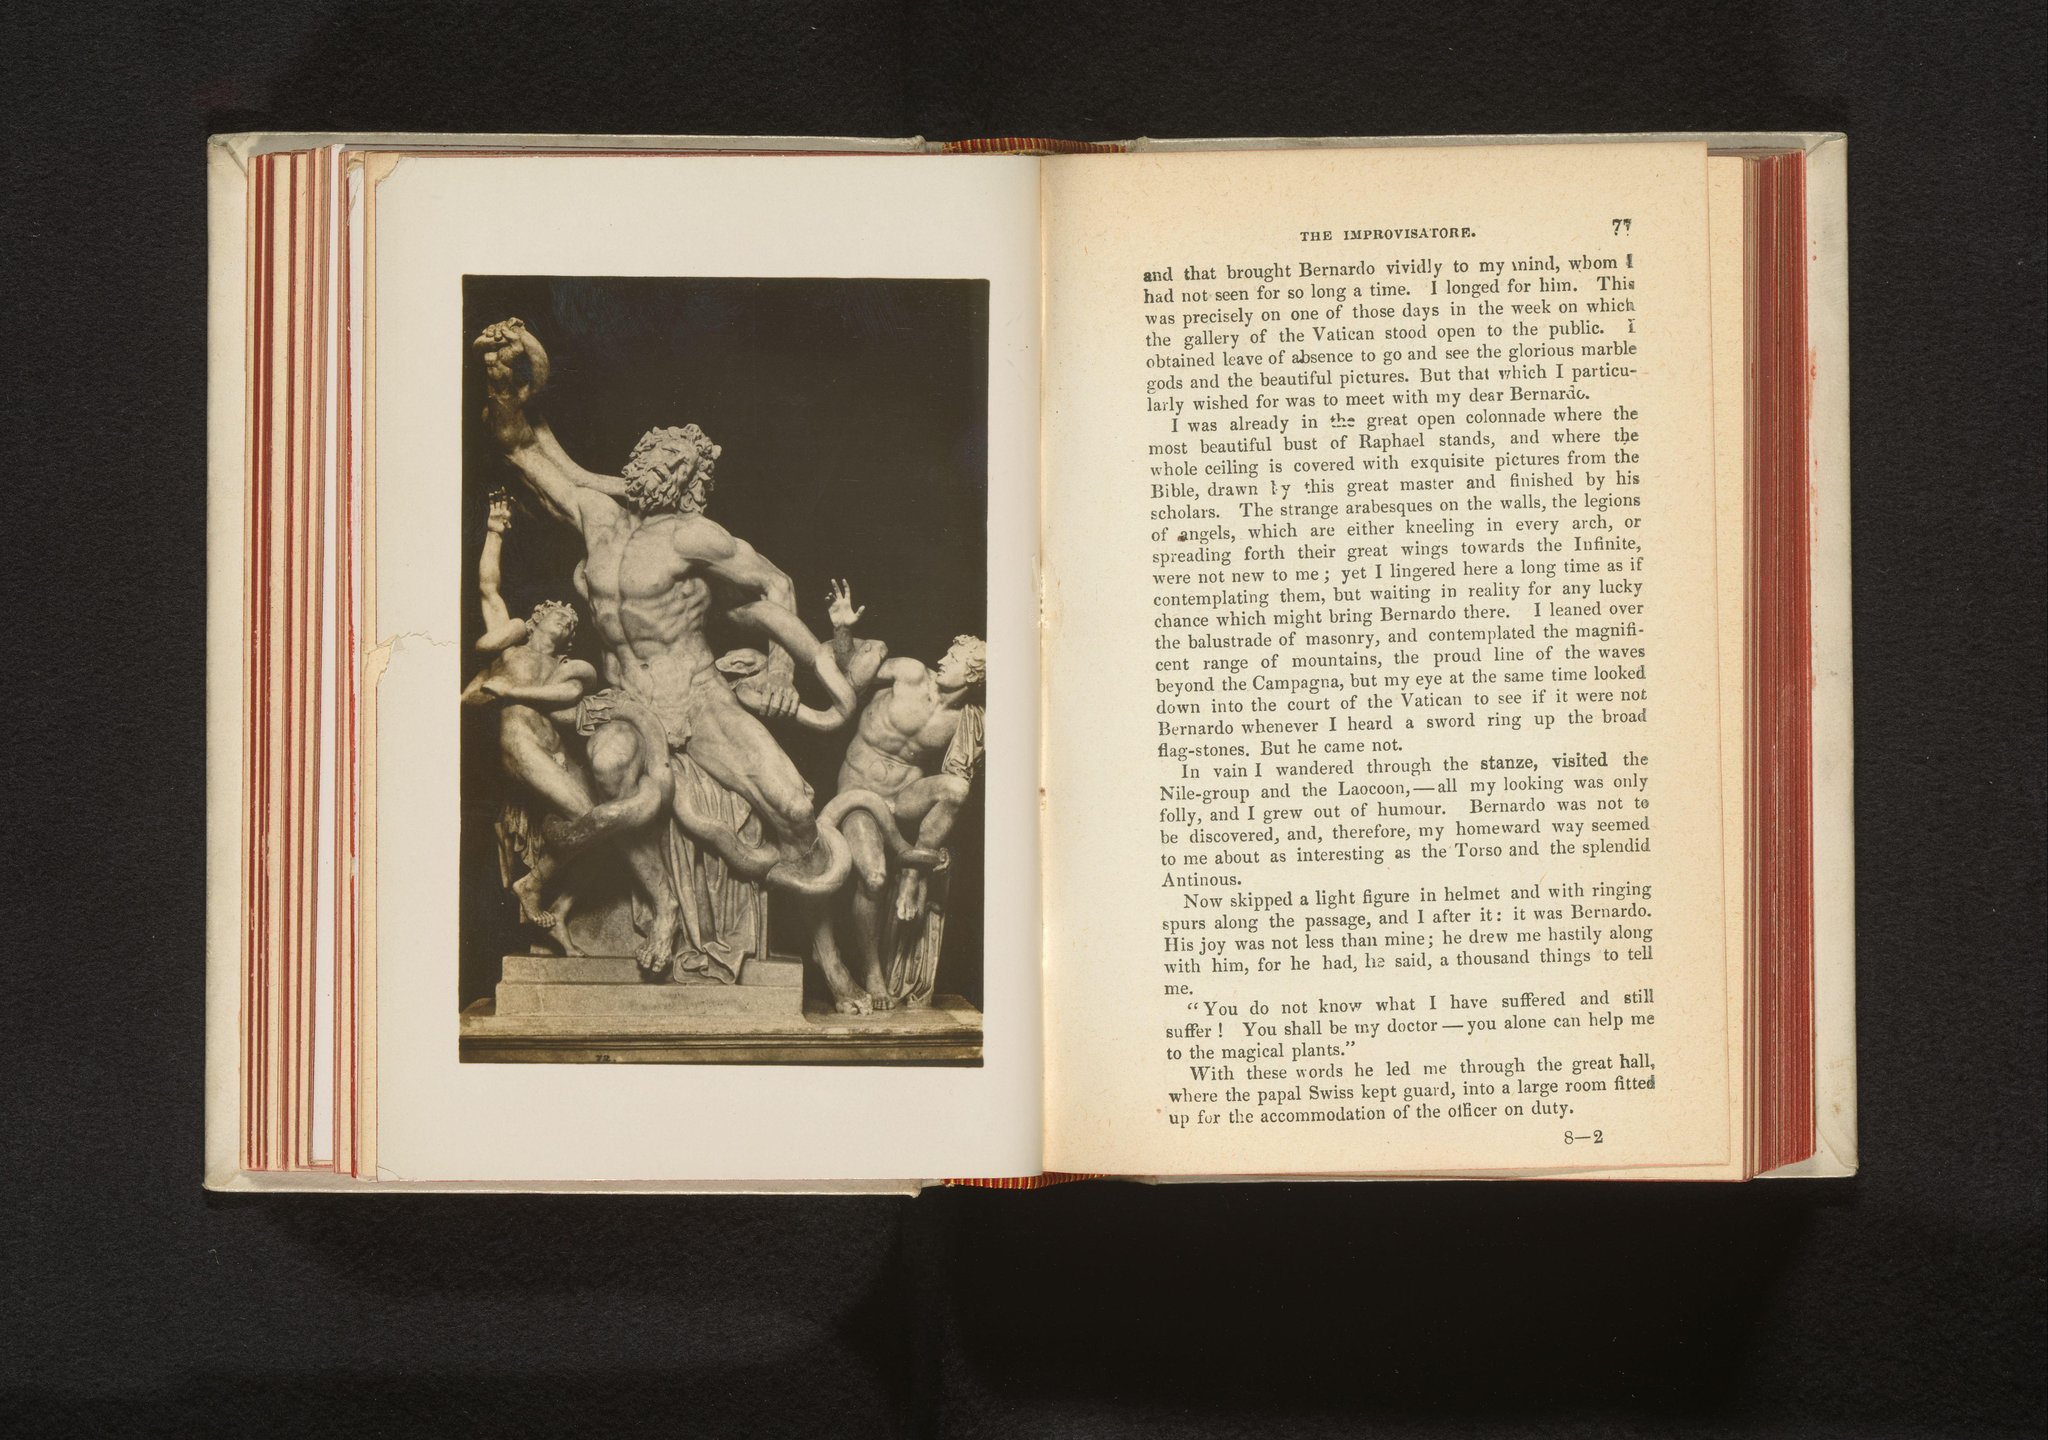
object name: photograph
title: Laocoöngroep in de Vaticaanse Musea te Vaticaanstad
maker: Anonymous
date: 1870-1880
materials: photographic support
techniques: gelatin silver print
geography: vatican museums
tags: laocoon and his twin sons are strangled by two serpents during the preparations for a sacrifice, sculpture